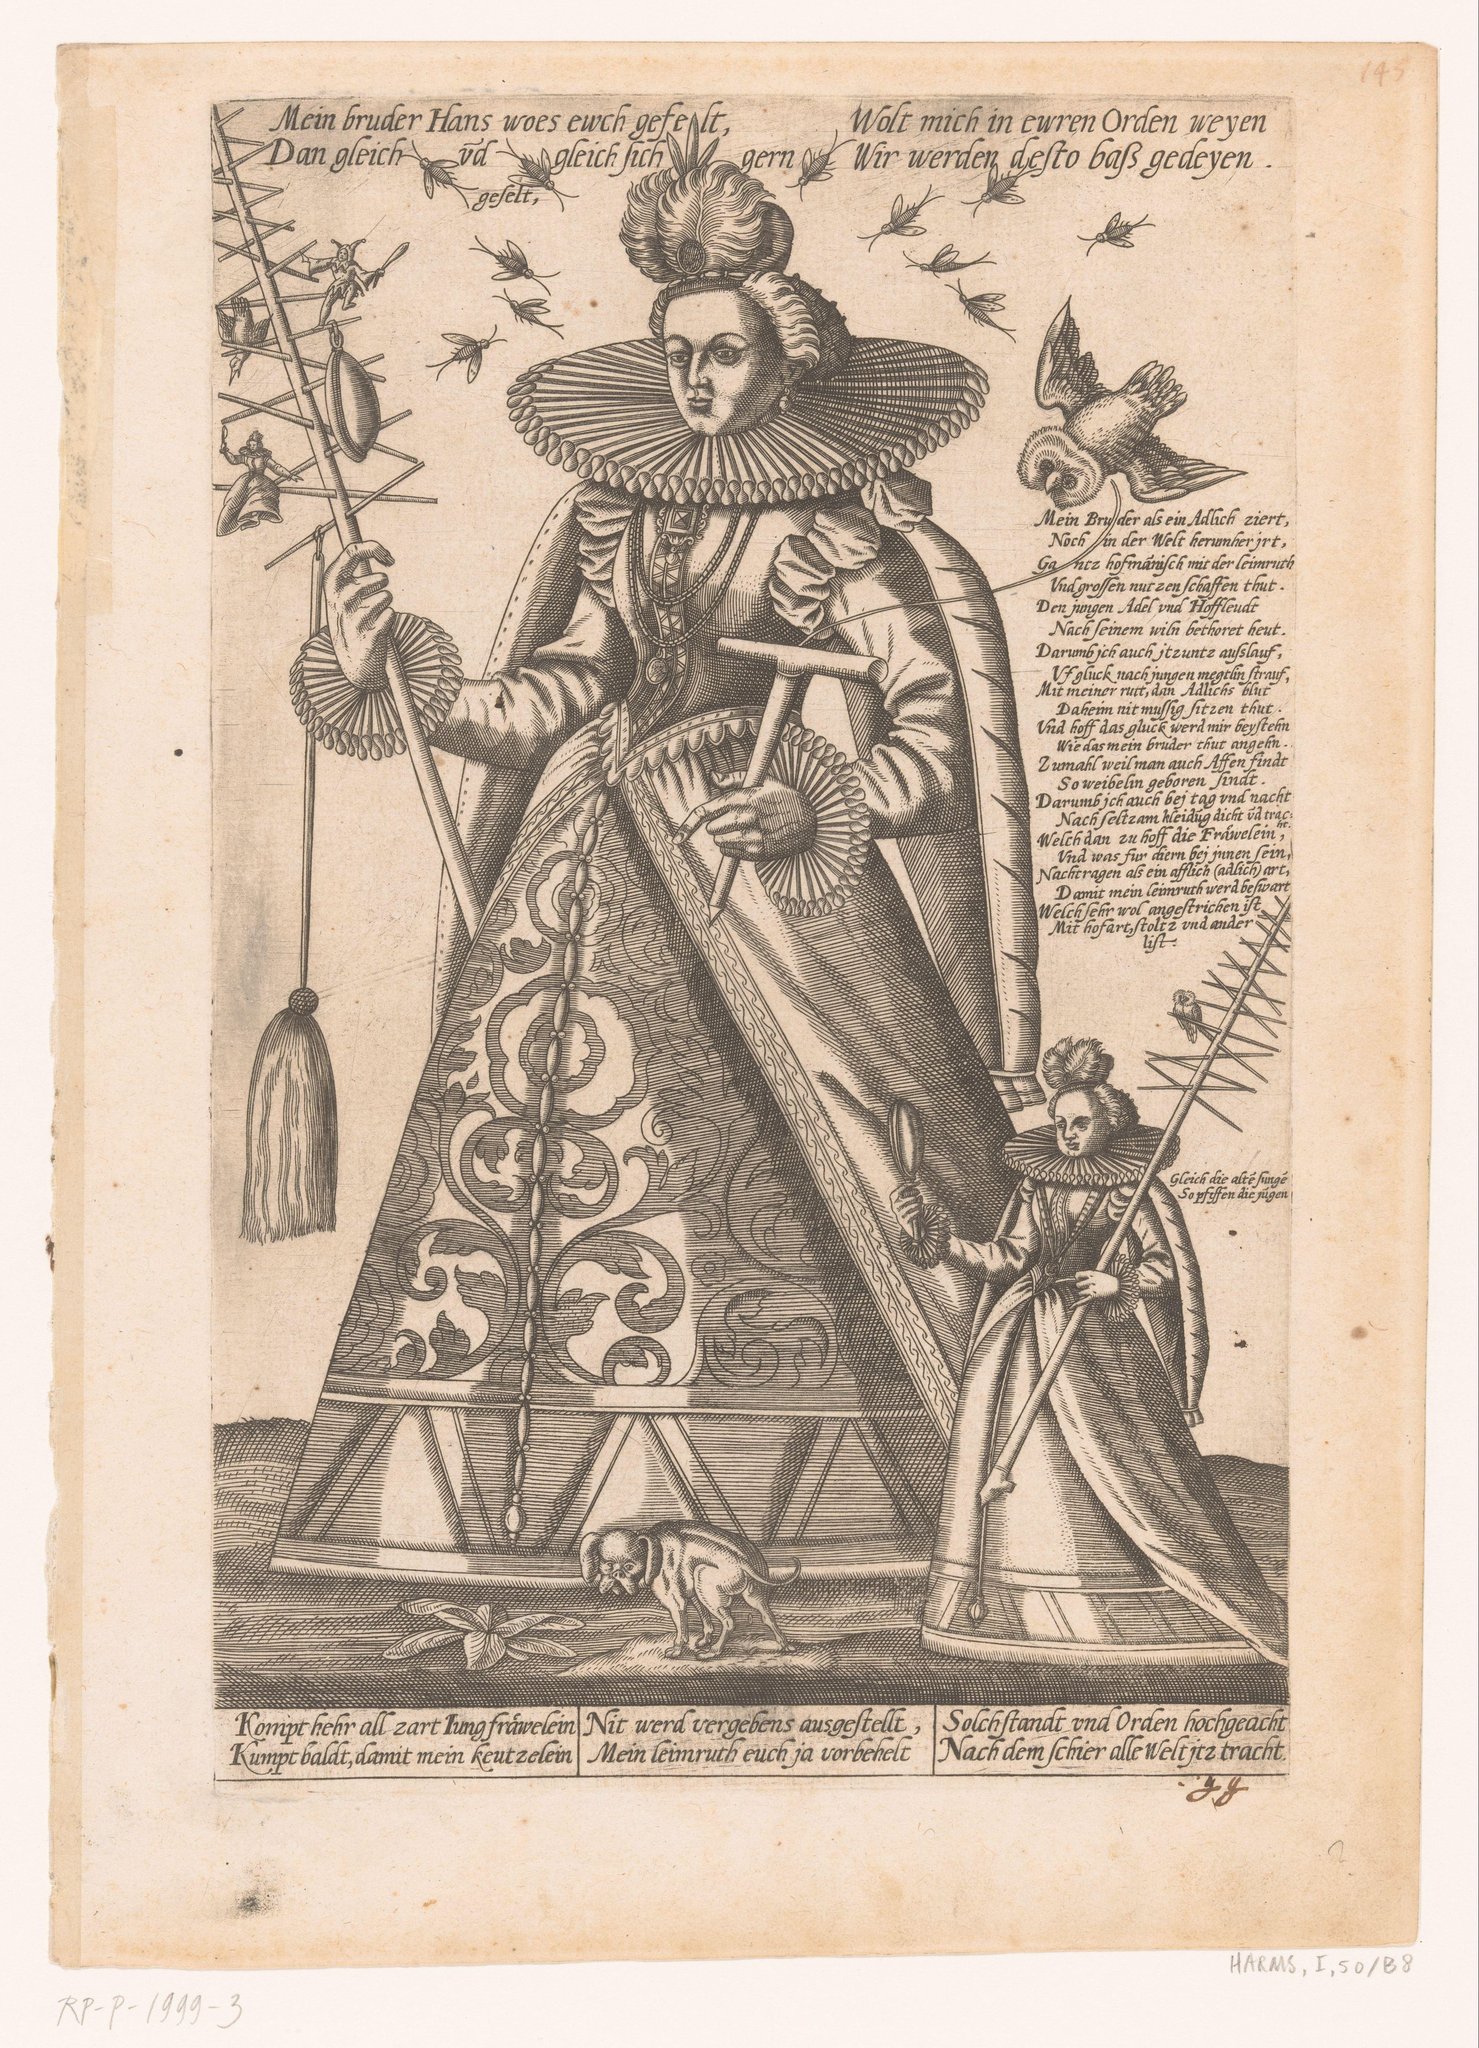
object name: pamphlet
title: Lijmstokloopster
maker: heinrich wirich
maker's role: print maker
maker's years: -1600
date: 1575-1600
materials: paper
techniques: engraving, etching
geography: germany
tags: fool, simpleton, numskull, bird hunting, folly, foolishness; 'pazzia', 'sciocchezza', 'stoltitia' (ripa), pamphlet ~ printed matter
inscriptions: collector's mark: Lugt 2228, collector's mark: Lugt 2760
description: Grote en kleine dame naast elkaar staand, elk een lijmstok (bedoeld om vogels mee te vangen) in de hand. Op de lijmstok van de grote dame zitten, behalve een vogel, een vrouw met spiegel en een nar geplakt. In de andere hand houdt ze een stok vast met uil eraan. De kleine dame heeft behalve de lijmstok een bolle spiegel in de hand waarin ze zichzelf bekijkt. Een poepende hond middenvoor. Boven het hoofd van de grote dame een zwerm muggen. Satire op de vrouwelijke dwaasheden, vooral de ijdelheid.